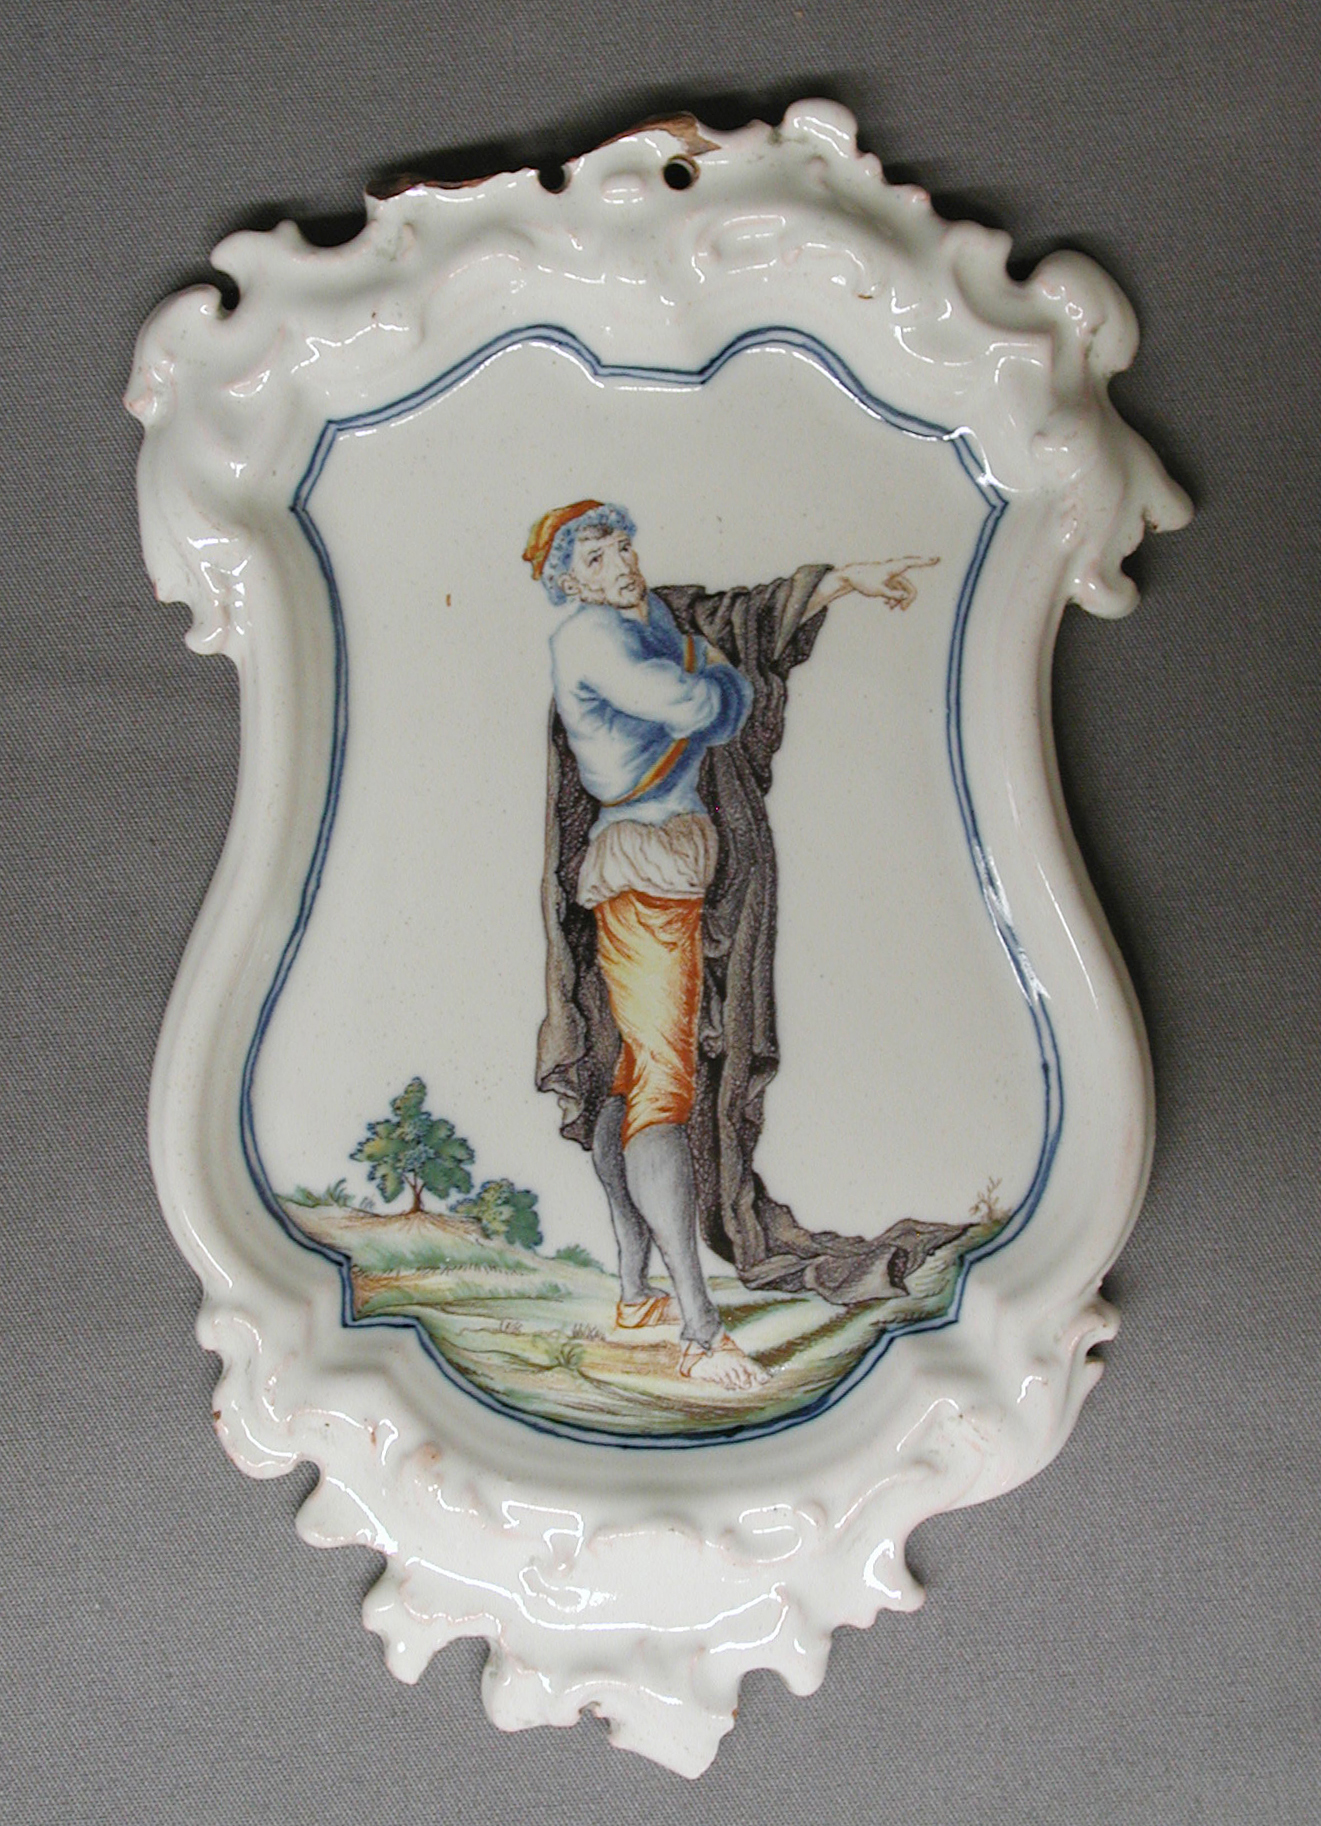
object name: plaque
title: Plaque (one of a pair)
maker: alcora manufactory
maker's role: factory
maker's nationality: spanish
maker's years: 1727-1895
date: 1755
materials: earthenware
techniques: enamel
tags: men,plants